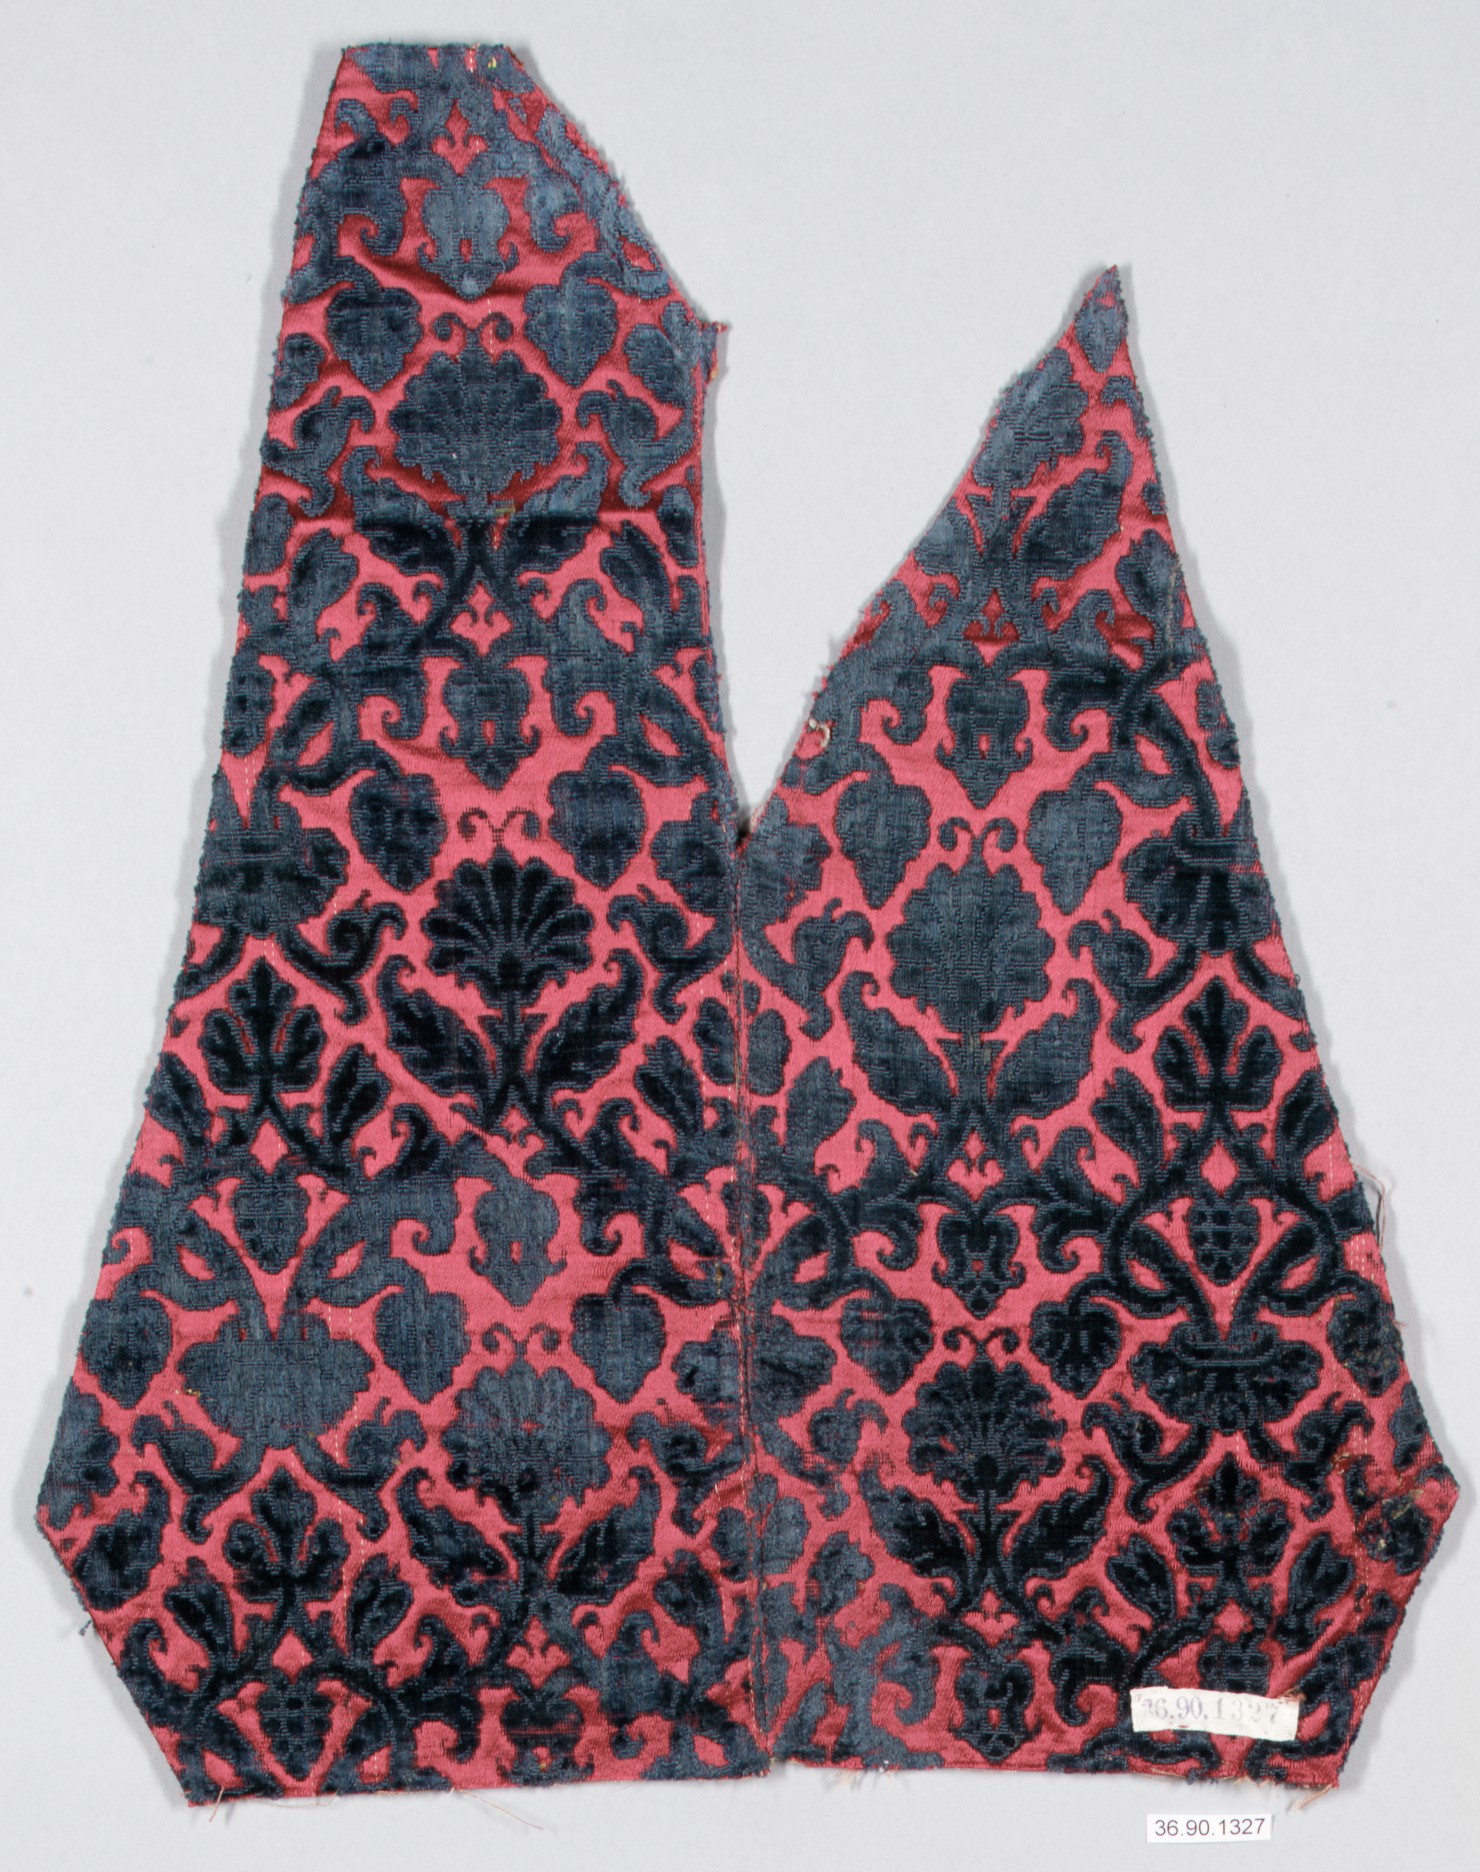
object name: piece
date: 1501-1700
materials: silk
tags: flowers,leaves